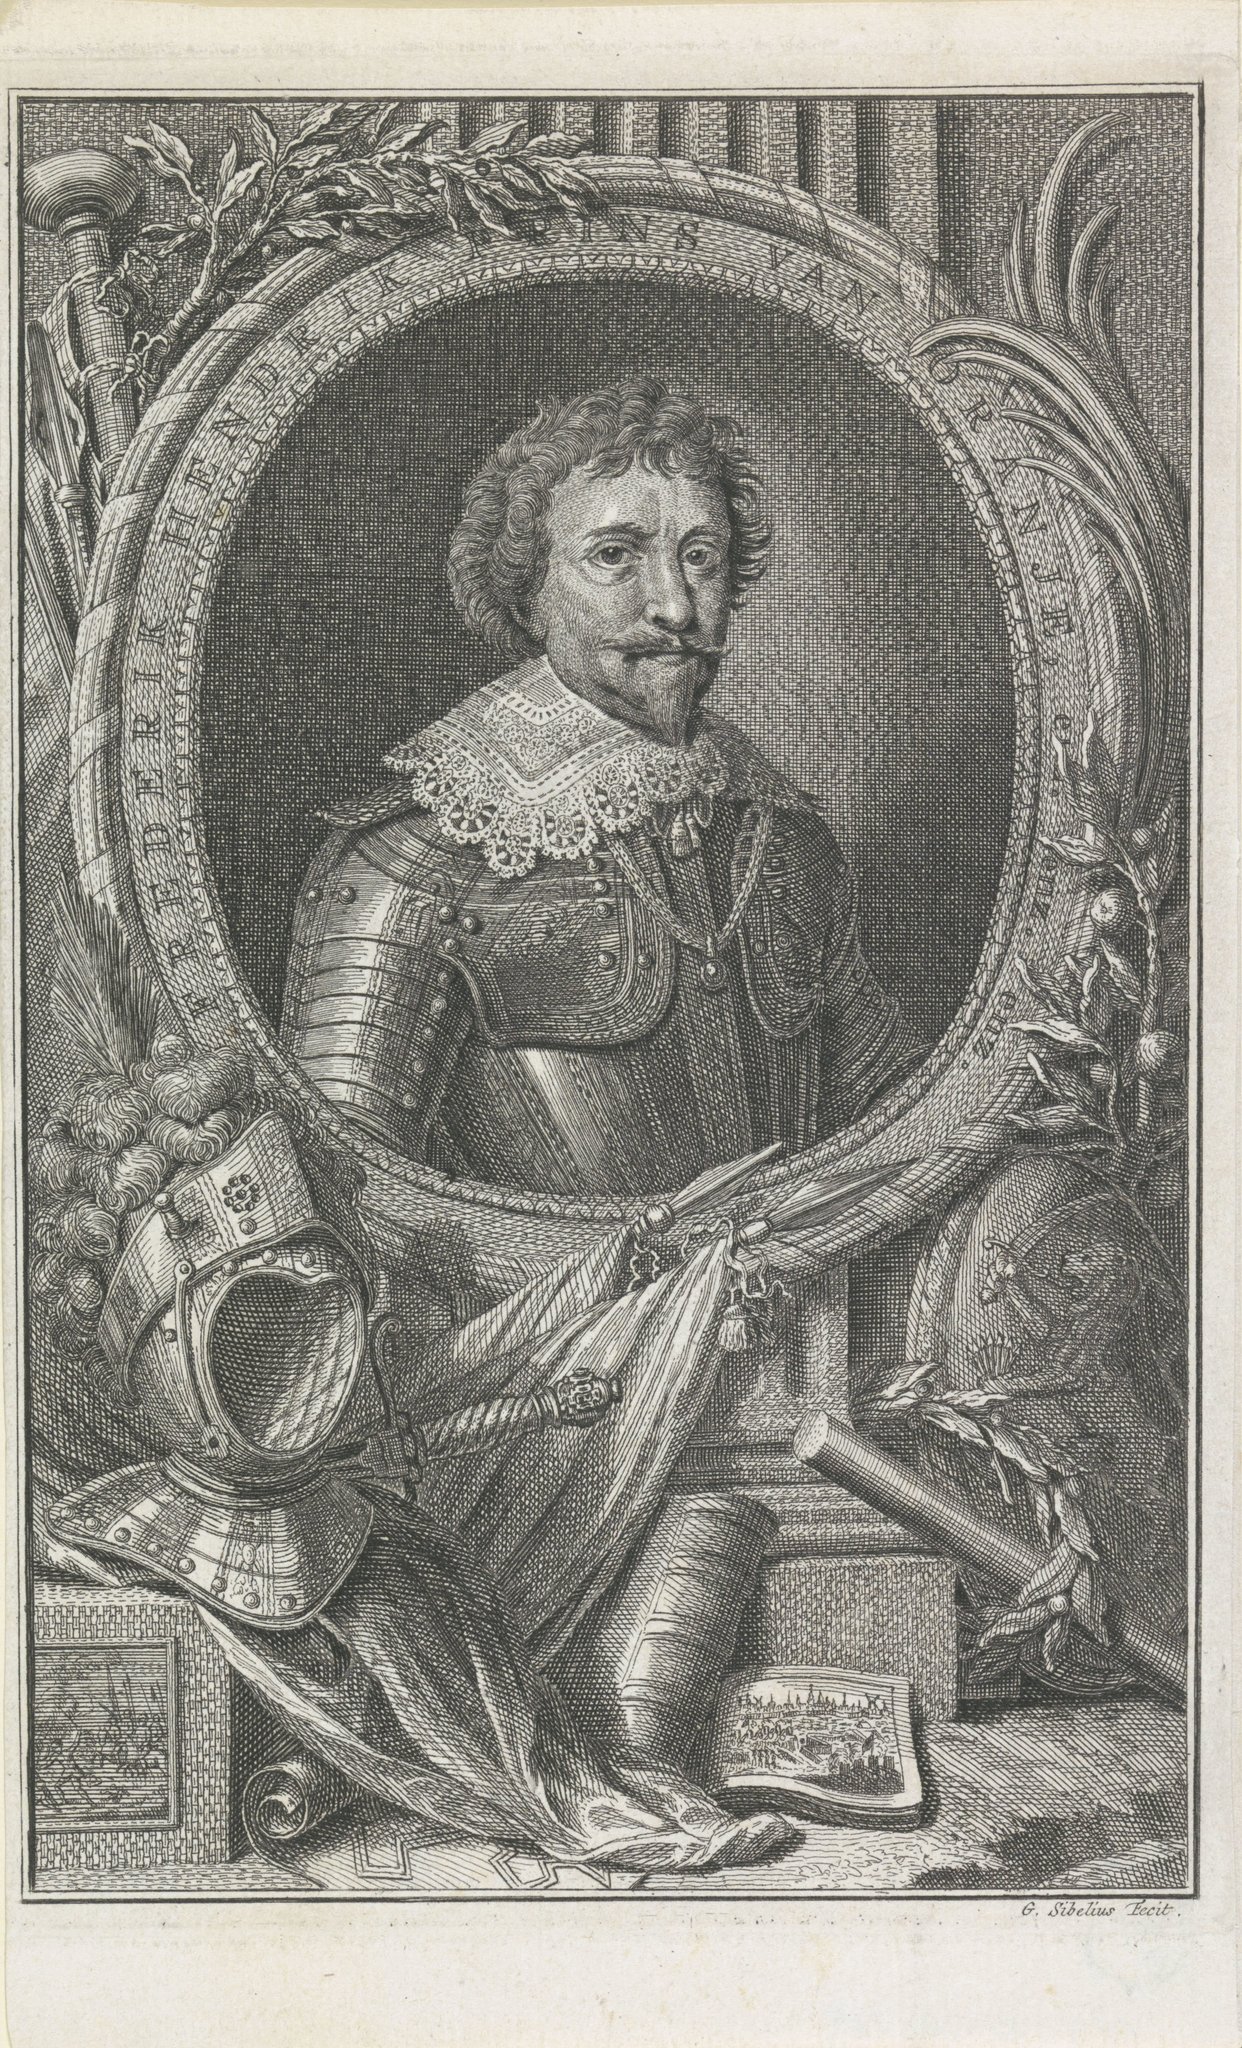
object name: print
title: Portret van Frederik Hendrik, prins van Oranje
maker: gerard sibelius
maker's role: print maker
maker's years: 1734-1785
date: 1755-1785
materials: paper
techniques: engraving, etching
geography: northern netherlands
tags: delft, the hague, frederick henry (prince of orange), knighthood order (garter) - insignia of a knighthood order, e.g.: badge, chain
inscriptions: collector's mark: Lugt 963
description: De hier vermelde titel verwijst naar de hoogst verkregen titel van de geportretteerde, niet per se naar de titel die de geportretteerde op deze voorstelling draagt.